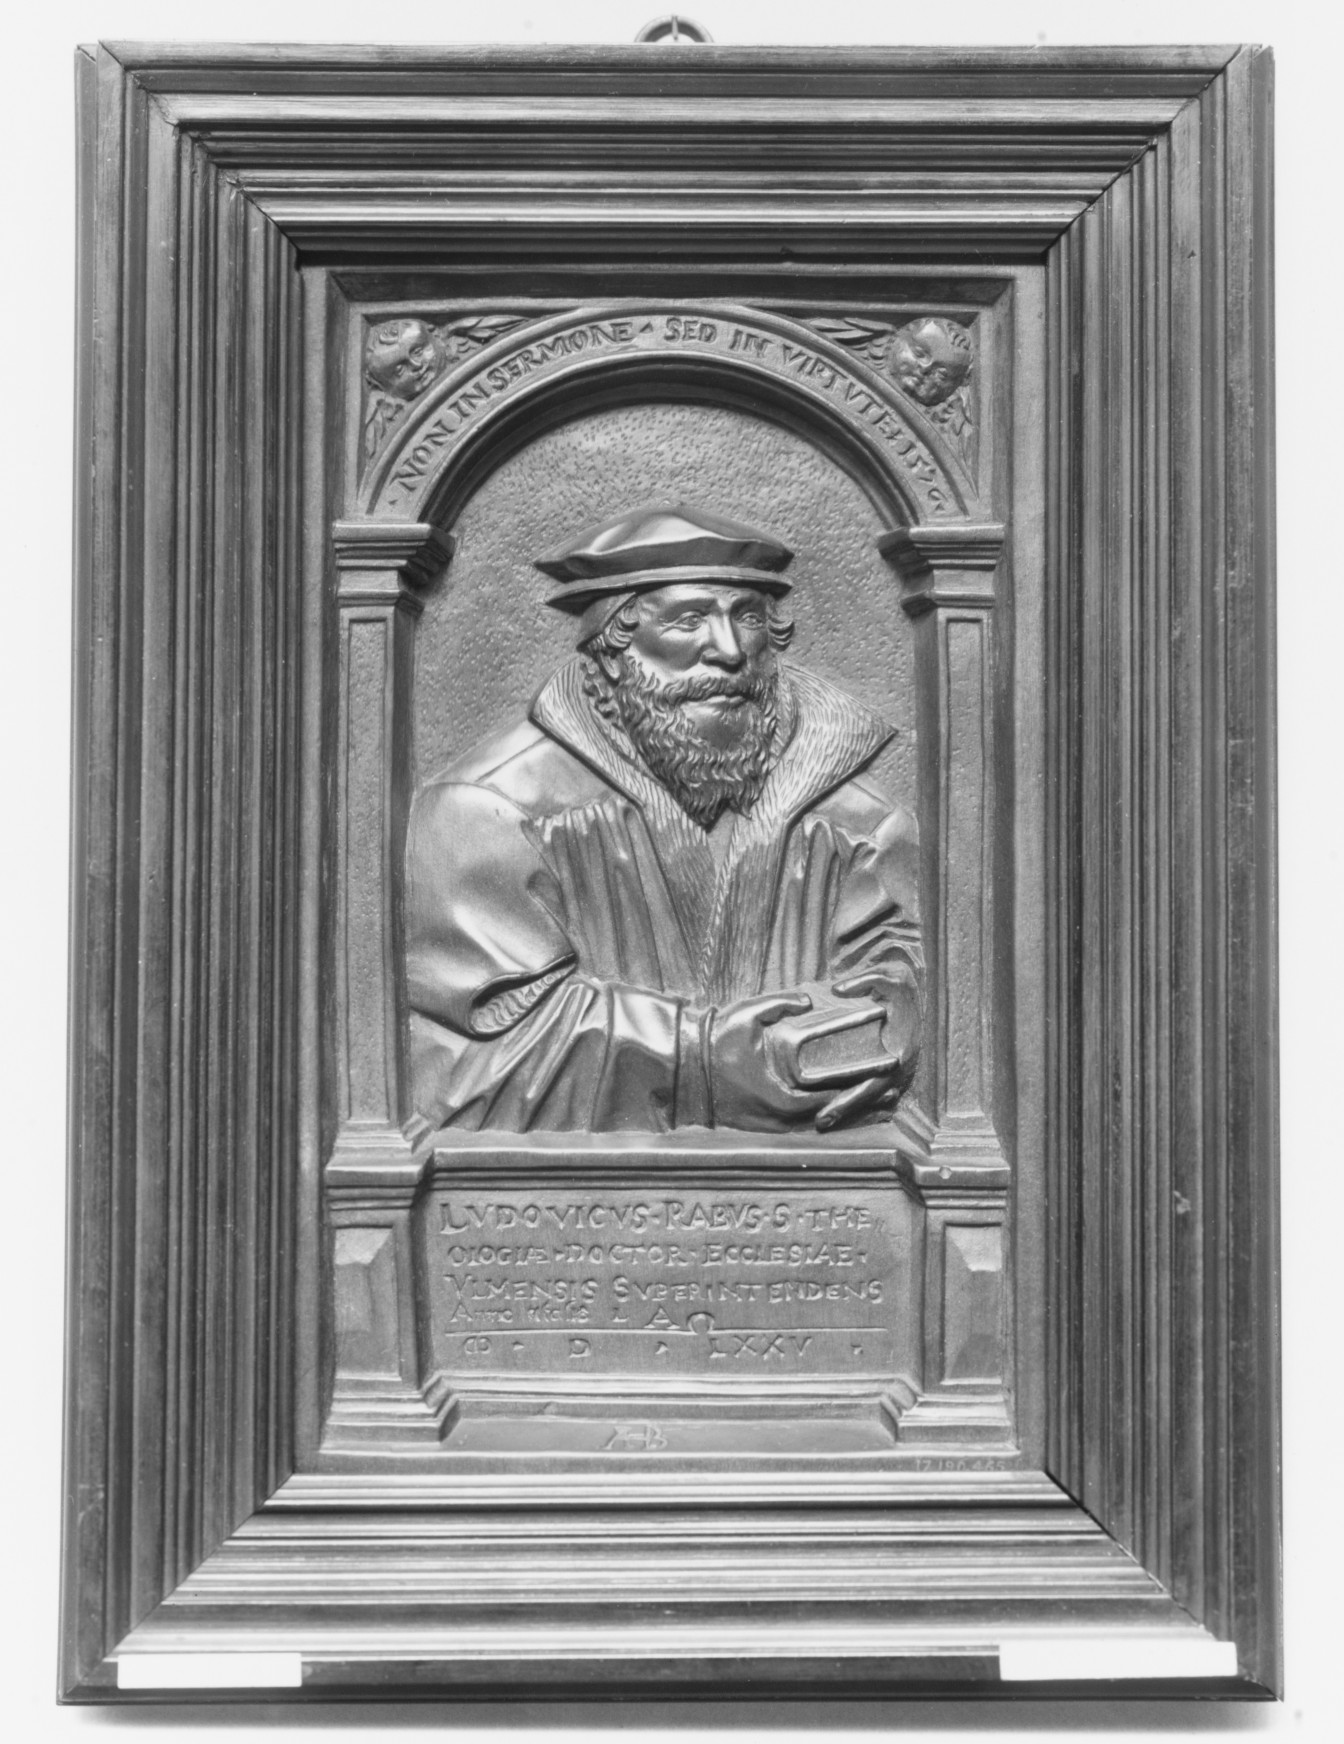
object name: plaque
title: Ludwig Raab, Ecclesiastic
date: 1576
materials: wood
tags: men,portraits